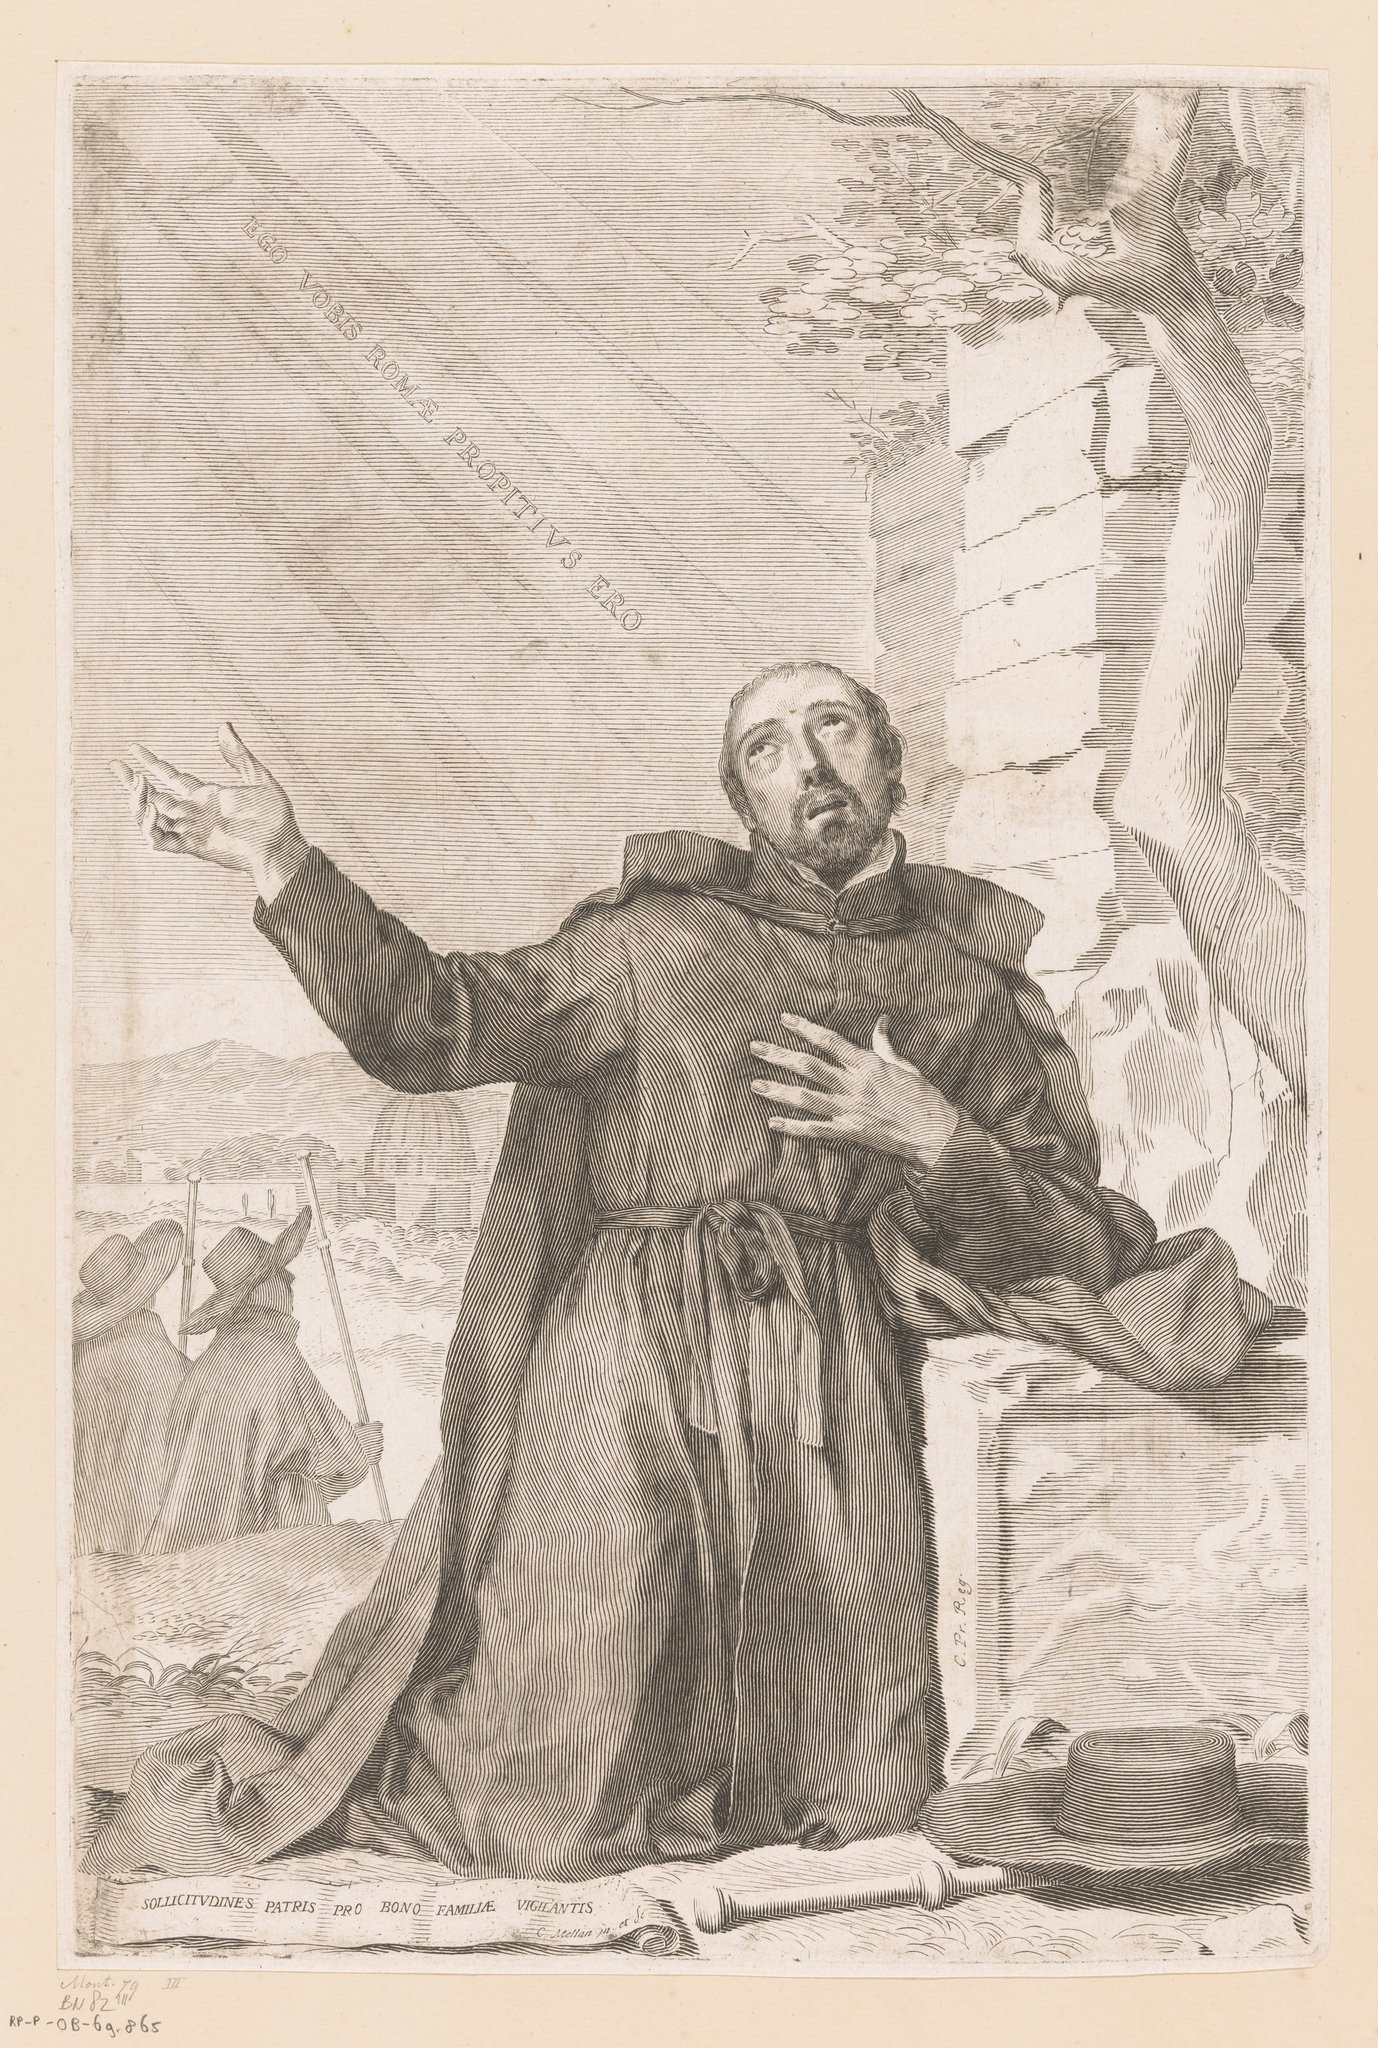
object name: print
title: H. Ignatius van Loyola in extase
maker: claude mellan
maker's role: draughtsman, print maker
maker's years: 1598-1688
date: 1608-1688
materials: paper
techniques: engraving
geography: france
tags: rome, clergyman, historical persons, pilgrimage, pilgrim(s) under way, visions of st. ignatius of loyola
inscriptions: collector's mark: Lugt 240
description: De heilige Ignatius van Loyola, knielend in extase voor een blok met reliëf. Op de achtergrond links lopen pelgrims naar Rome.